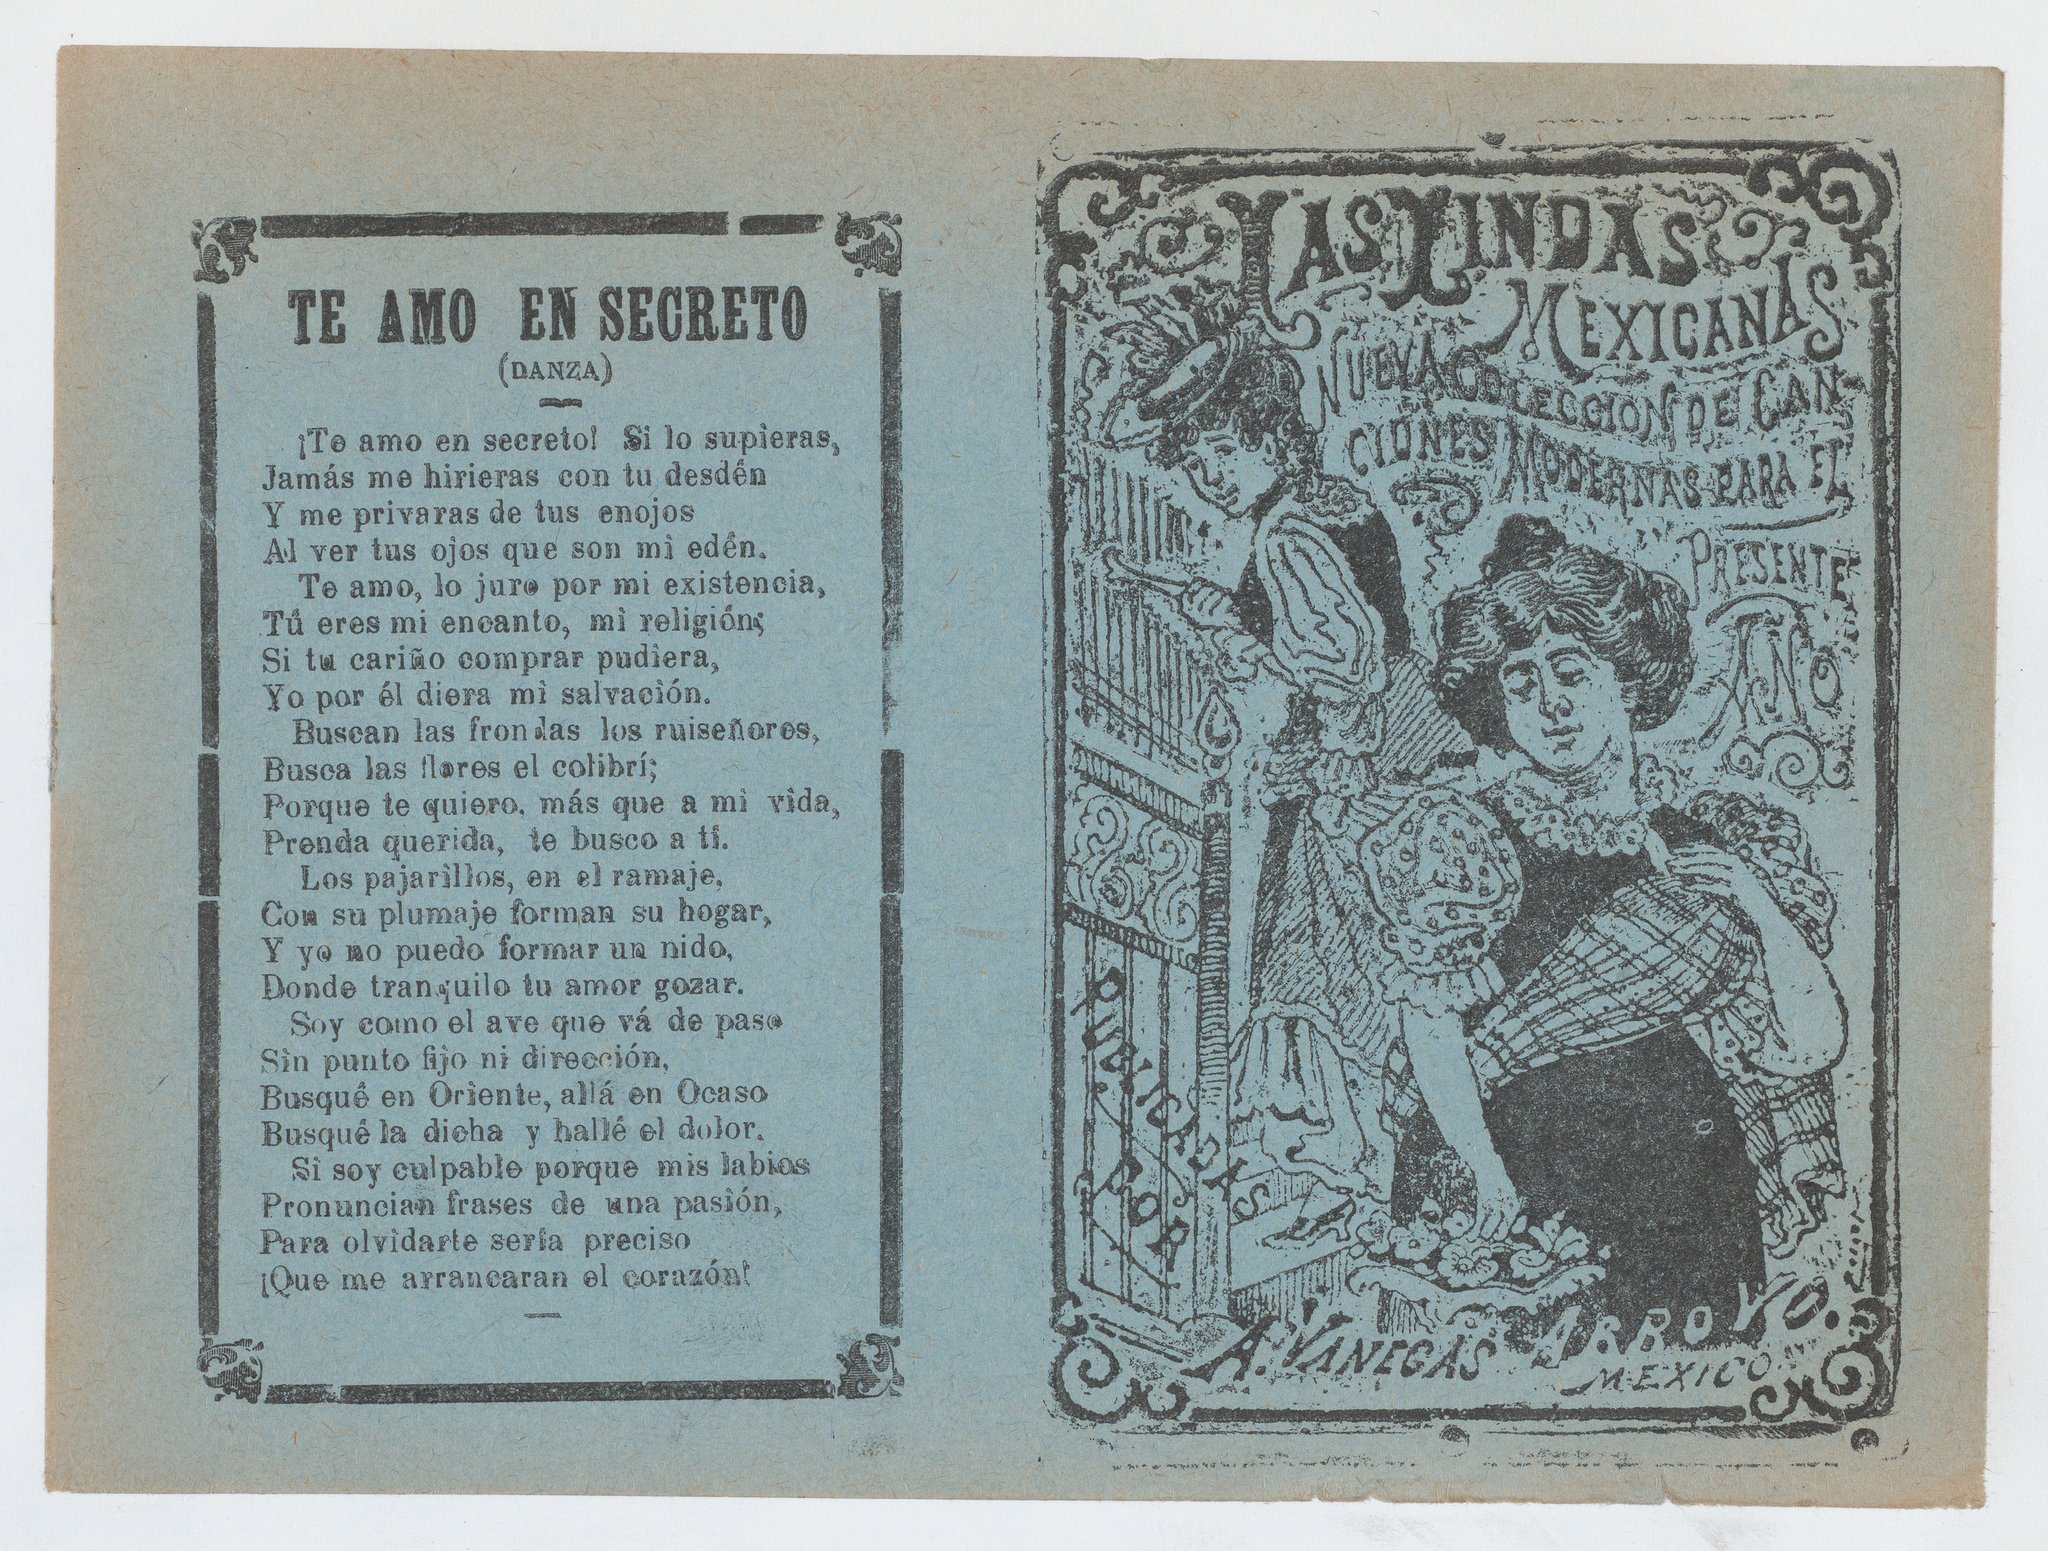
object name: print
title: Cover for 'Las Lindas Mexicanas', two elegantly dressed women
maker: josé guadalupe posada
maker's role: artist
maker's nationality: mexican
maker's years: 1852-1913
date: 1890-1910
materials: paper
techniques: letterpress, printing, lithography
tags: women